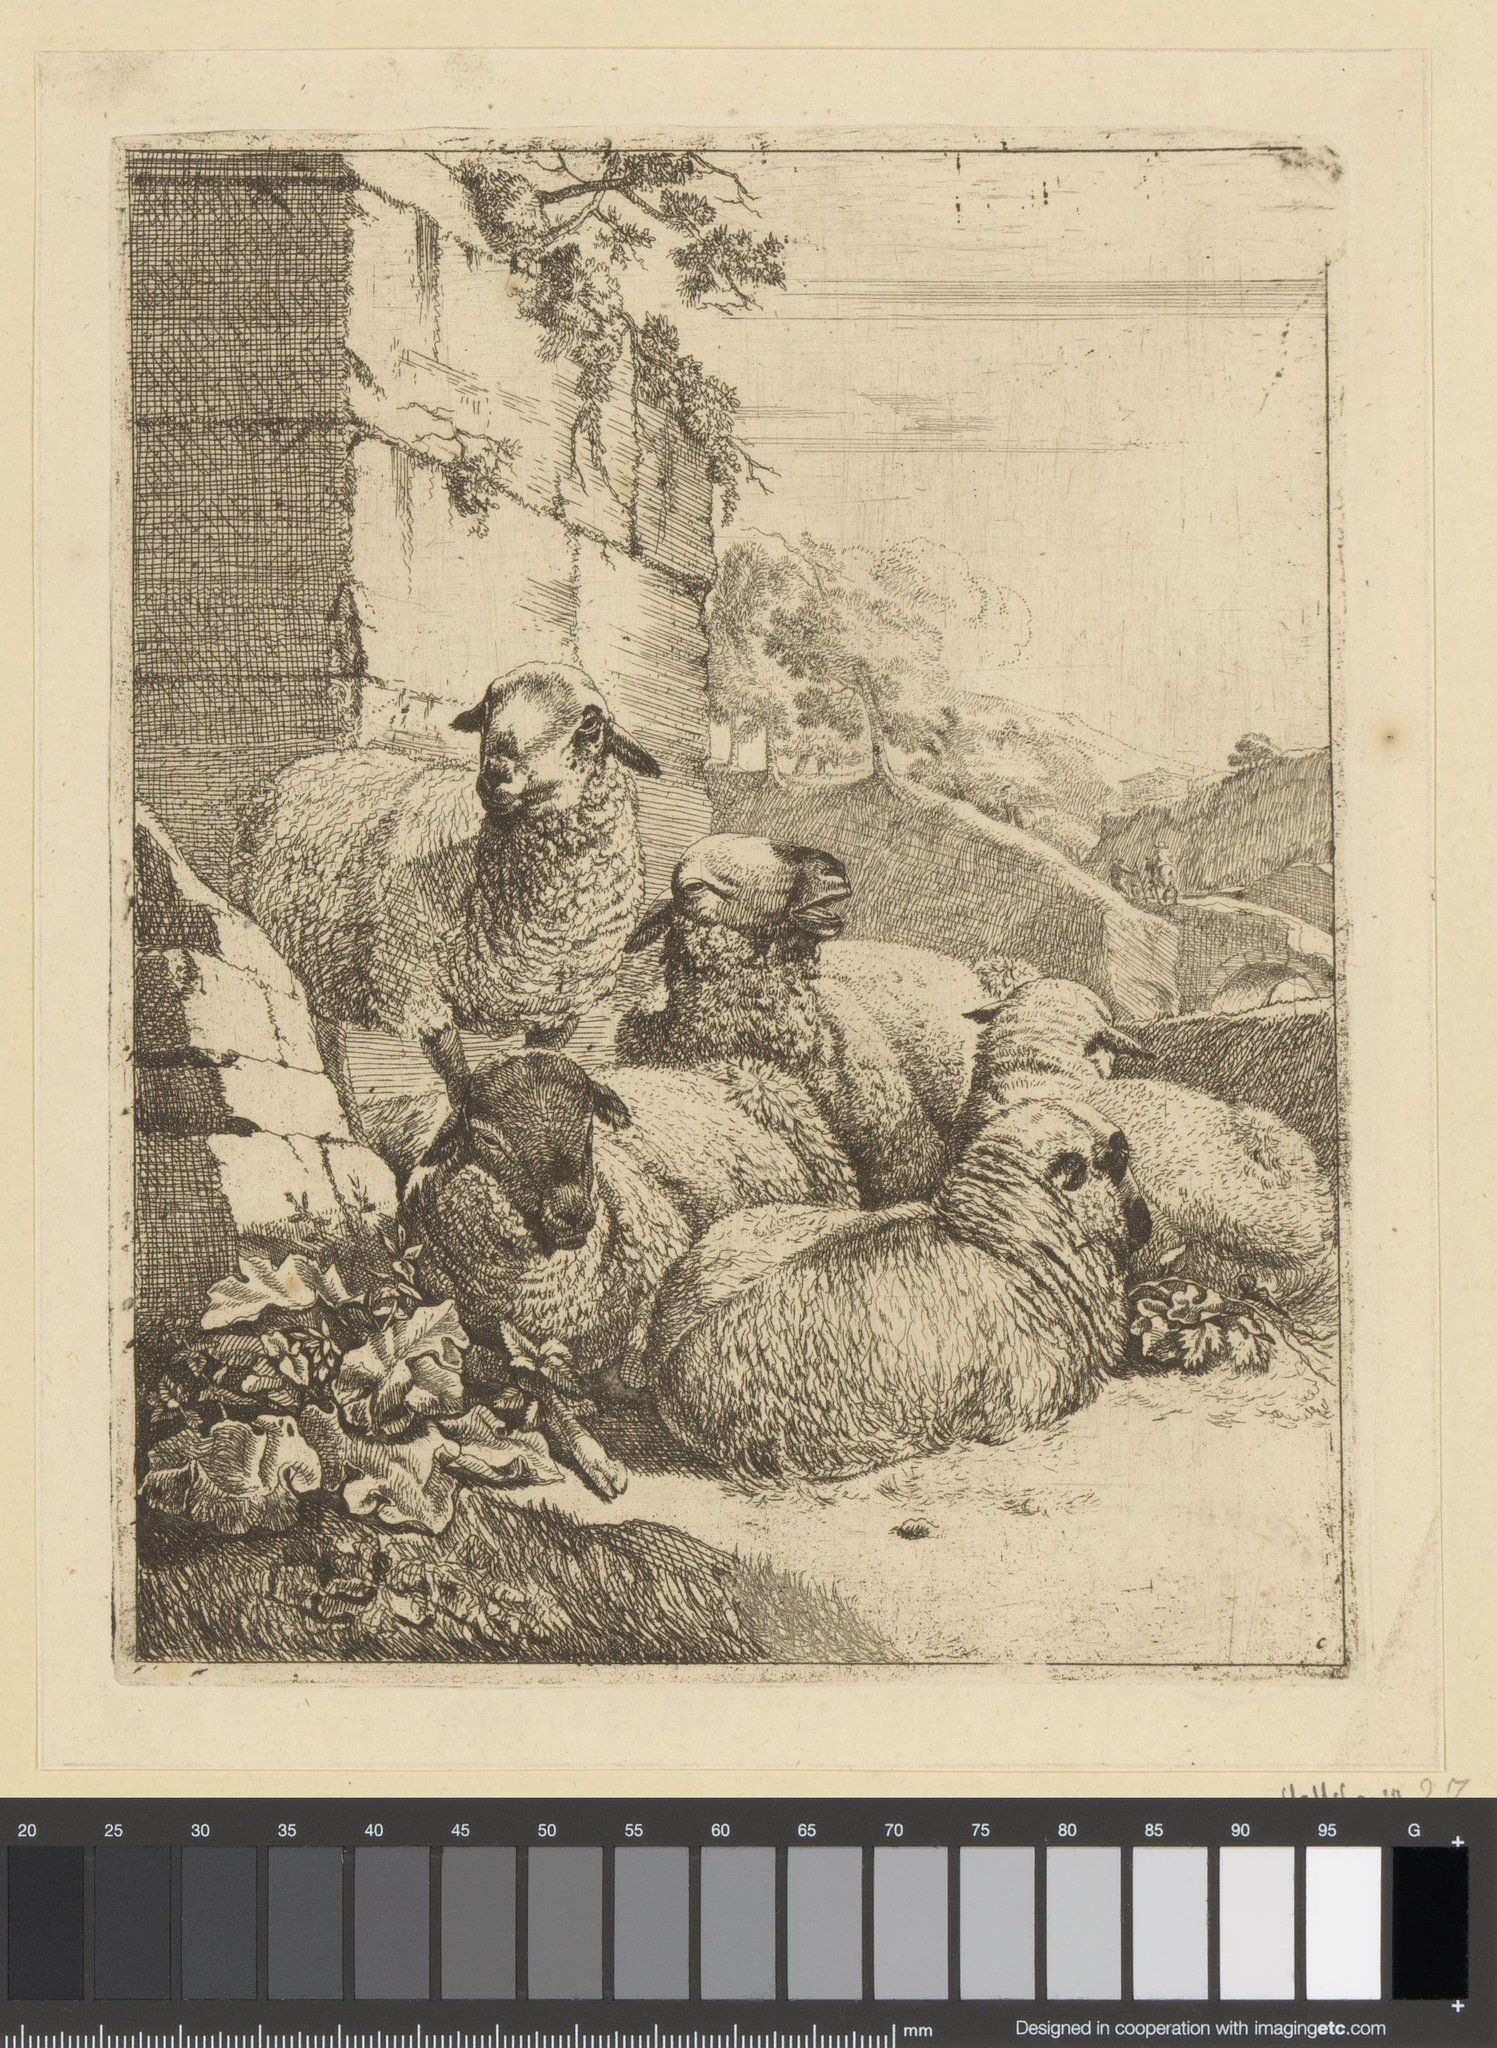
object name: print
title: Vier liggende en een staand schaap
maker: johann heinrich roos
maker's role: draughtsman, print maker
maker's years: 1631-1685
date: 1668-1670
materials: paper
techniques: engraving, etching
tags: landscape with ruins, sheep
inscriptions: collector's mark: Lugt 240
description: Serie van twaalf prenten, waarvan één titelprent. Deze staat rechtsonder genummerd met een c.